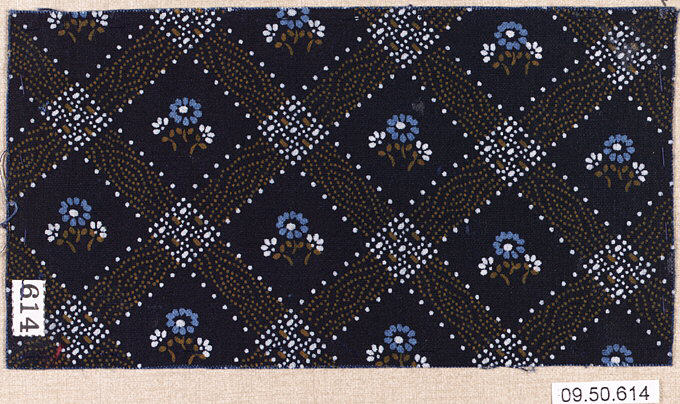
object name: piece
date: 1801-1900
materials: cotton